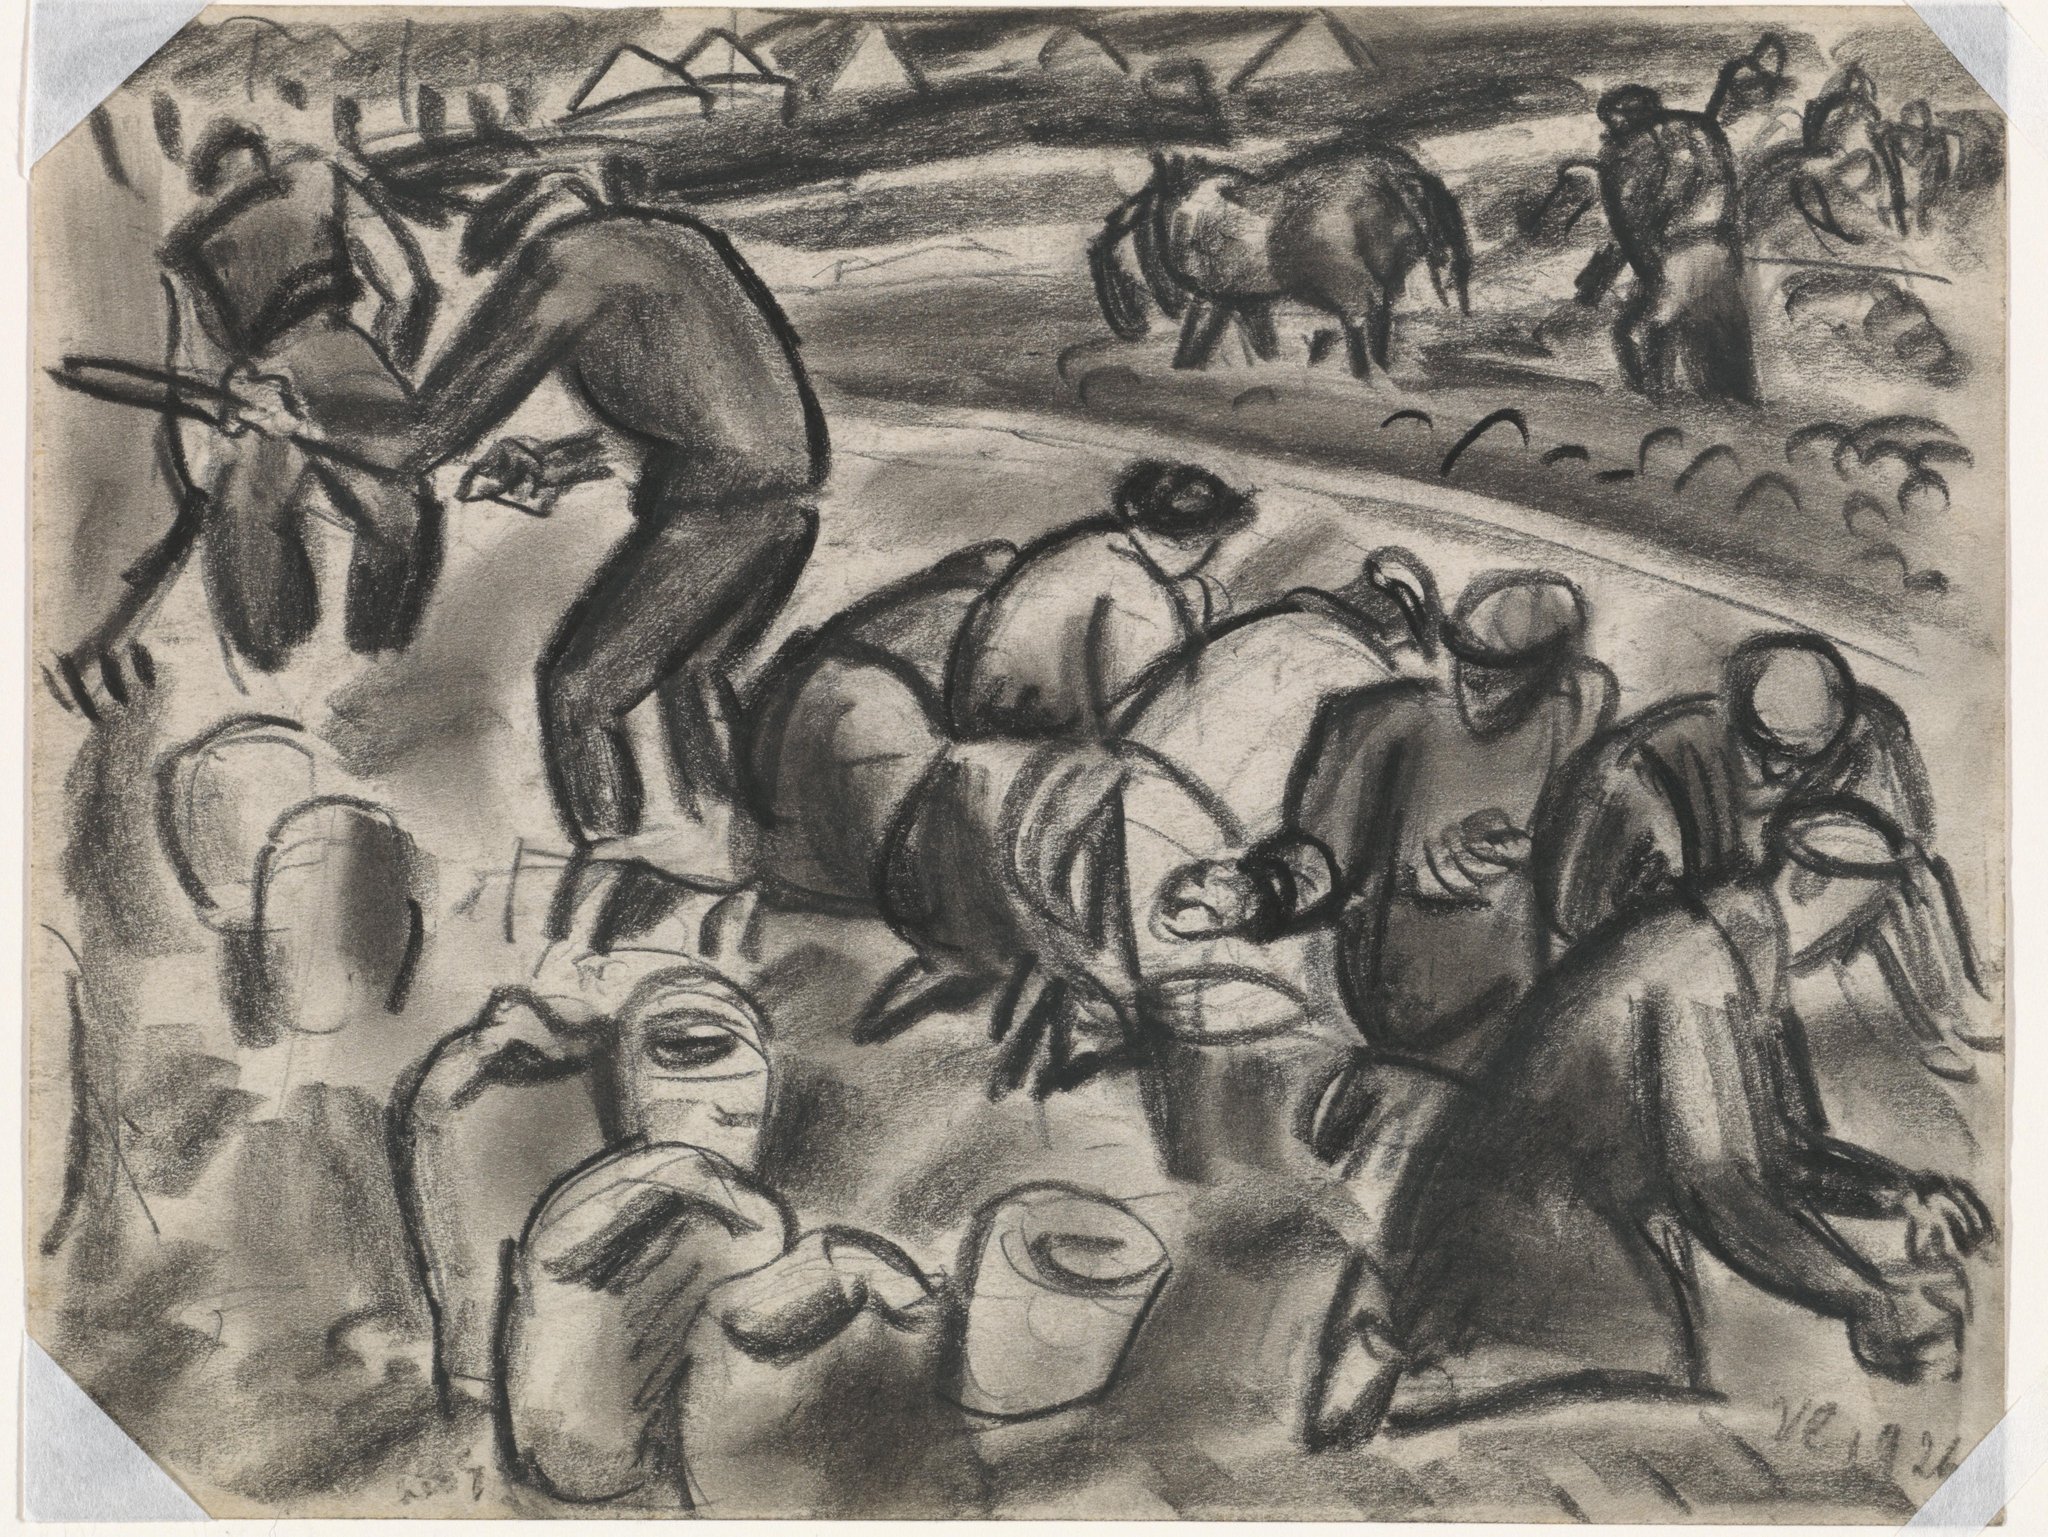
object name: drawing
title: Zonder titel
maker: leo gestel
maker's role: draughtsman, print maker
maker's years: 1881-1941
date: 1926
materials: chalk, charcoal, paper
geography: flanders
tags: potatoes, reaping, picking, mowing ~ harvest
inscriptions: date: ‘VL 1926’, signature: ‘Leo G.’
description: Aardappelrooiers werkend op het land, op de voorgrond boeren knielende op de grond, op achtergrond ploegende boer met paard.